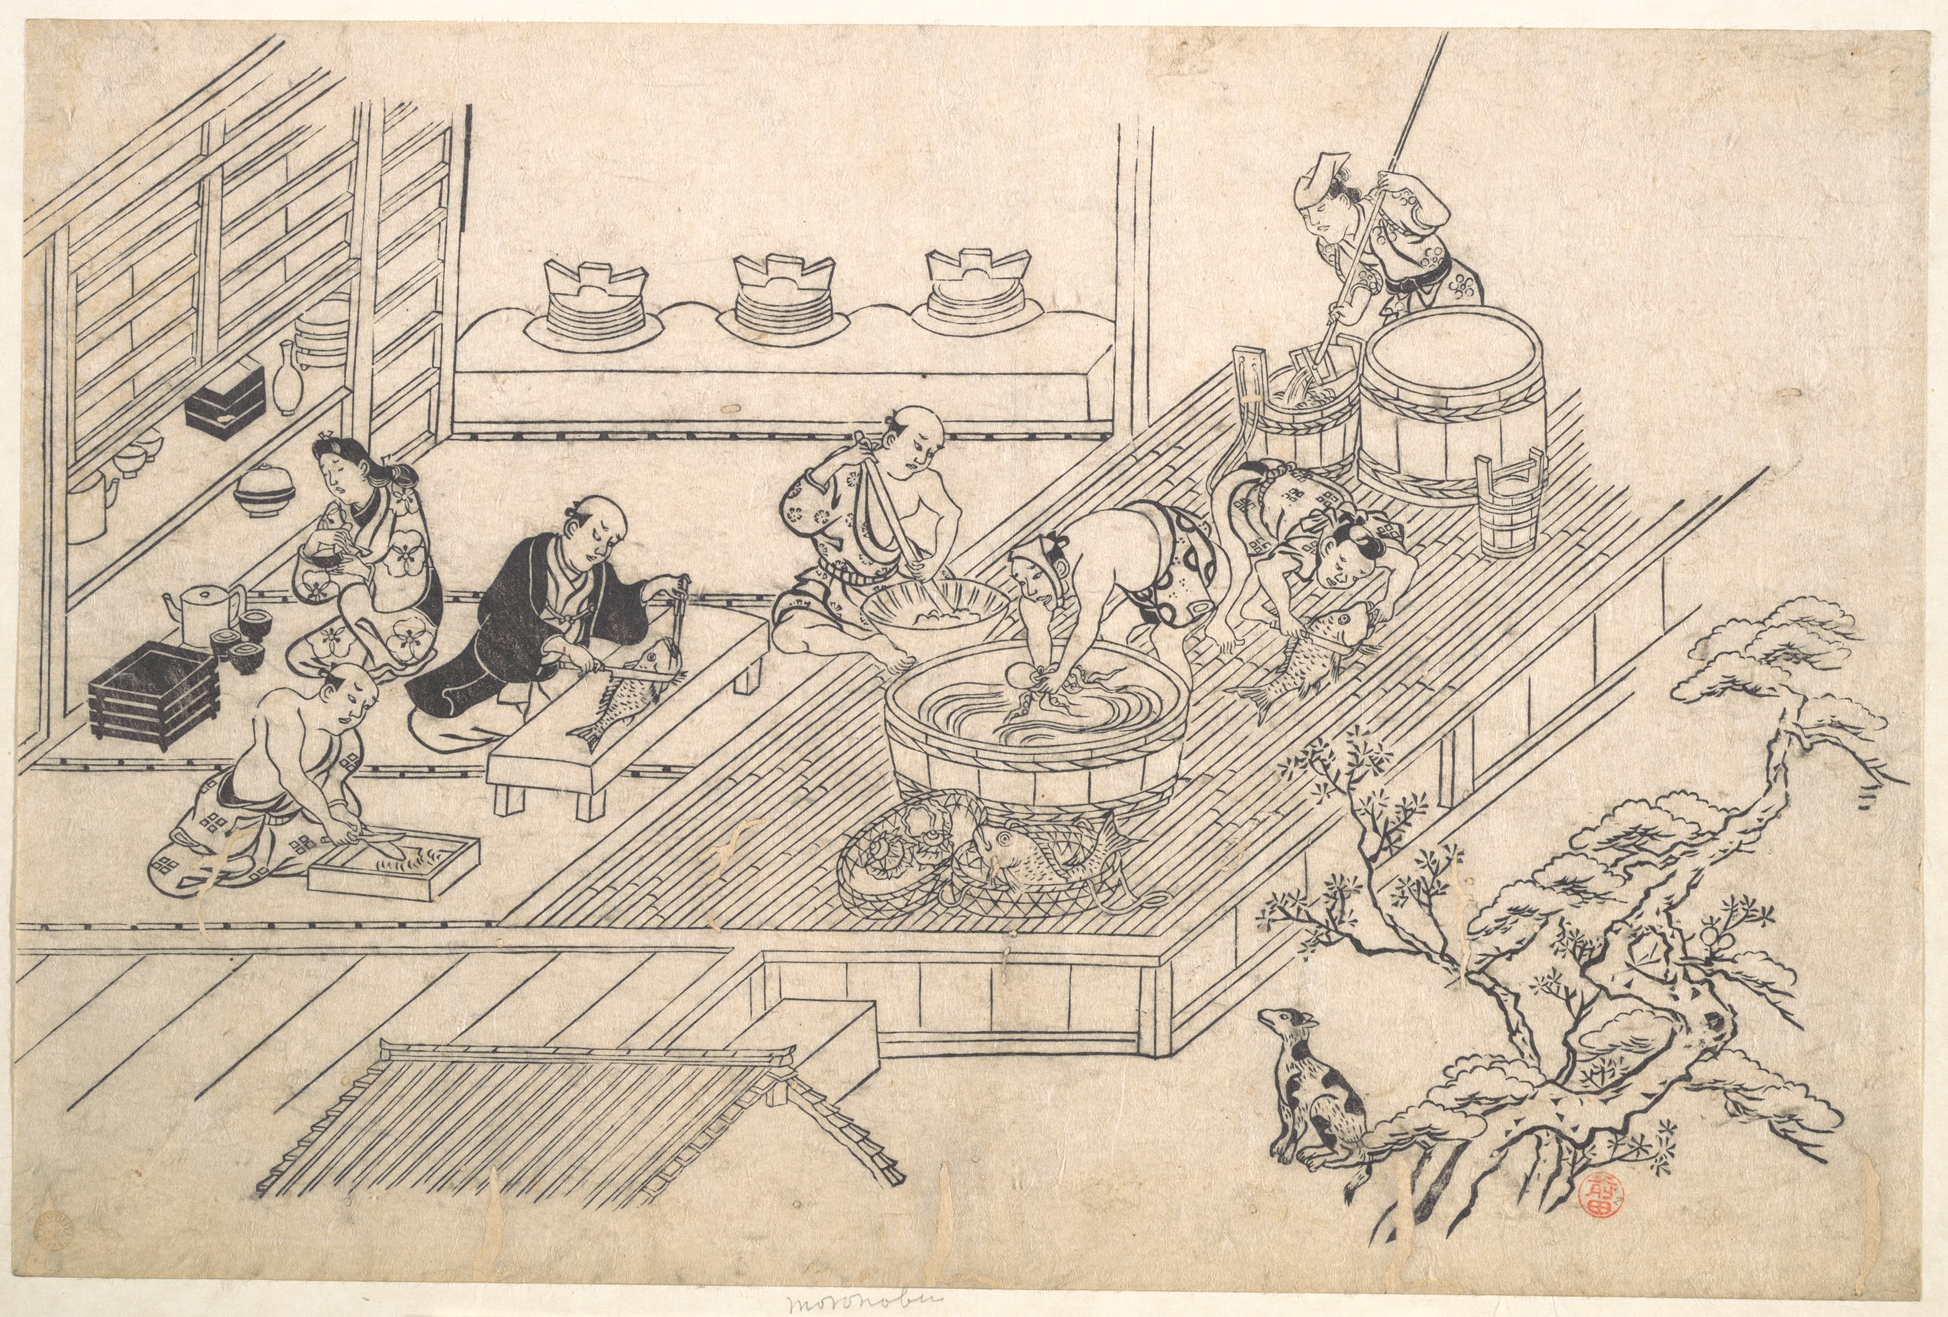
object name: print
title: The Kitchen of a Joroya.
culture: japanese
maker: hishikawa moronobu 菱川師宣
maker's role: artist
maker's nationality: japanese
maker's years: 1618-1694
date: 1680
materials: ink, paper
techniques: woodblock print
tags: kitchens,men,women,fish,working